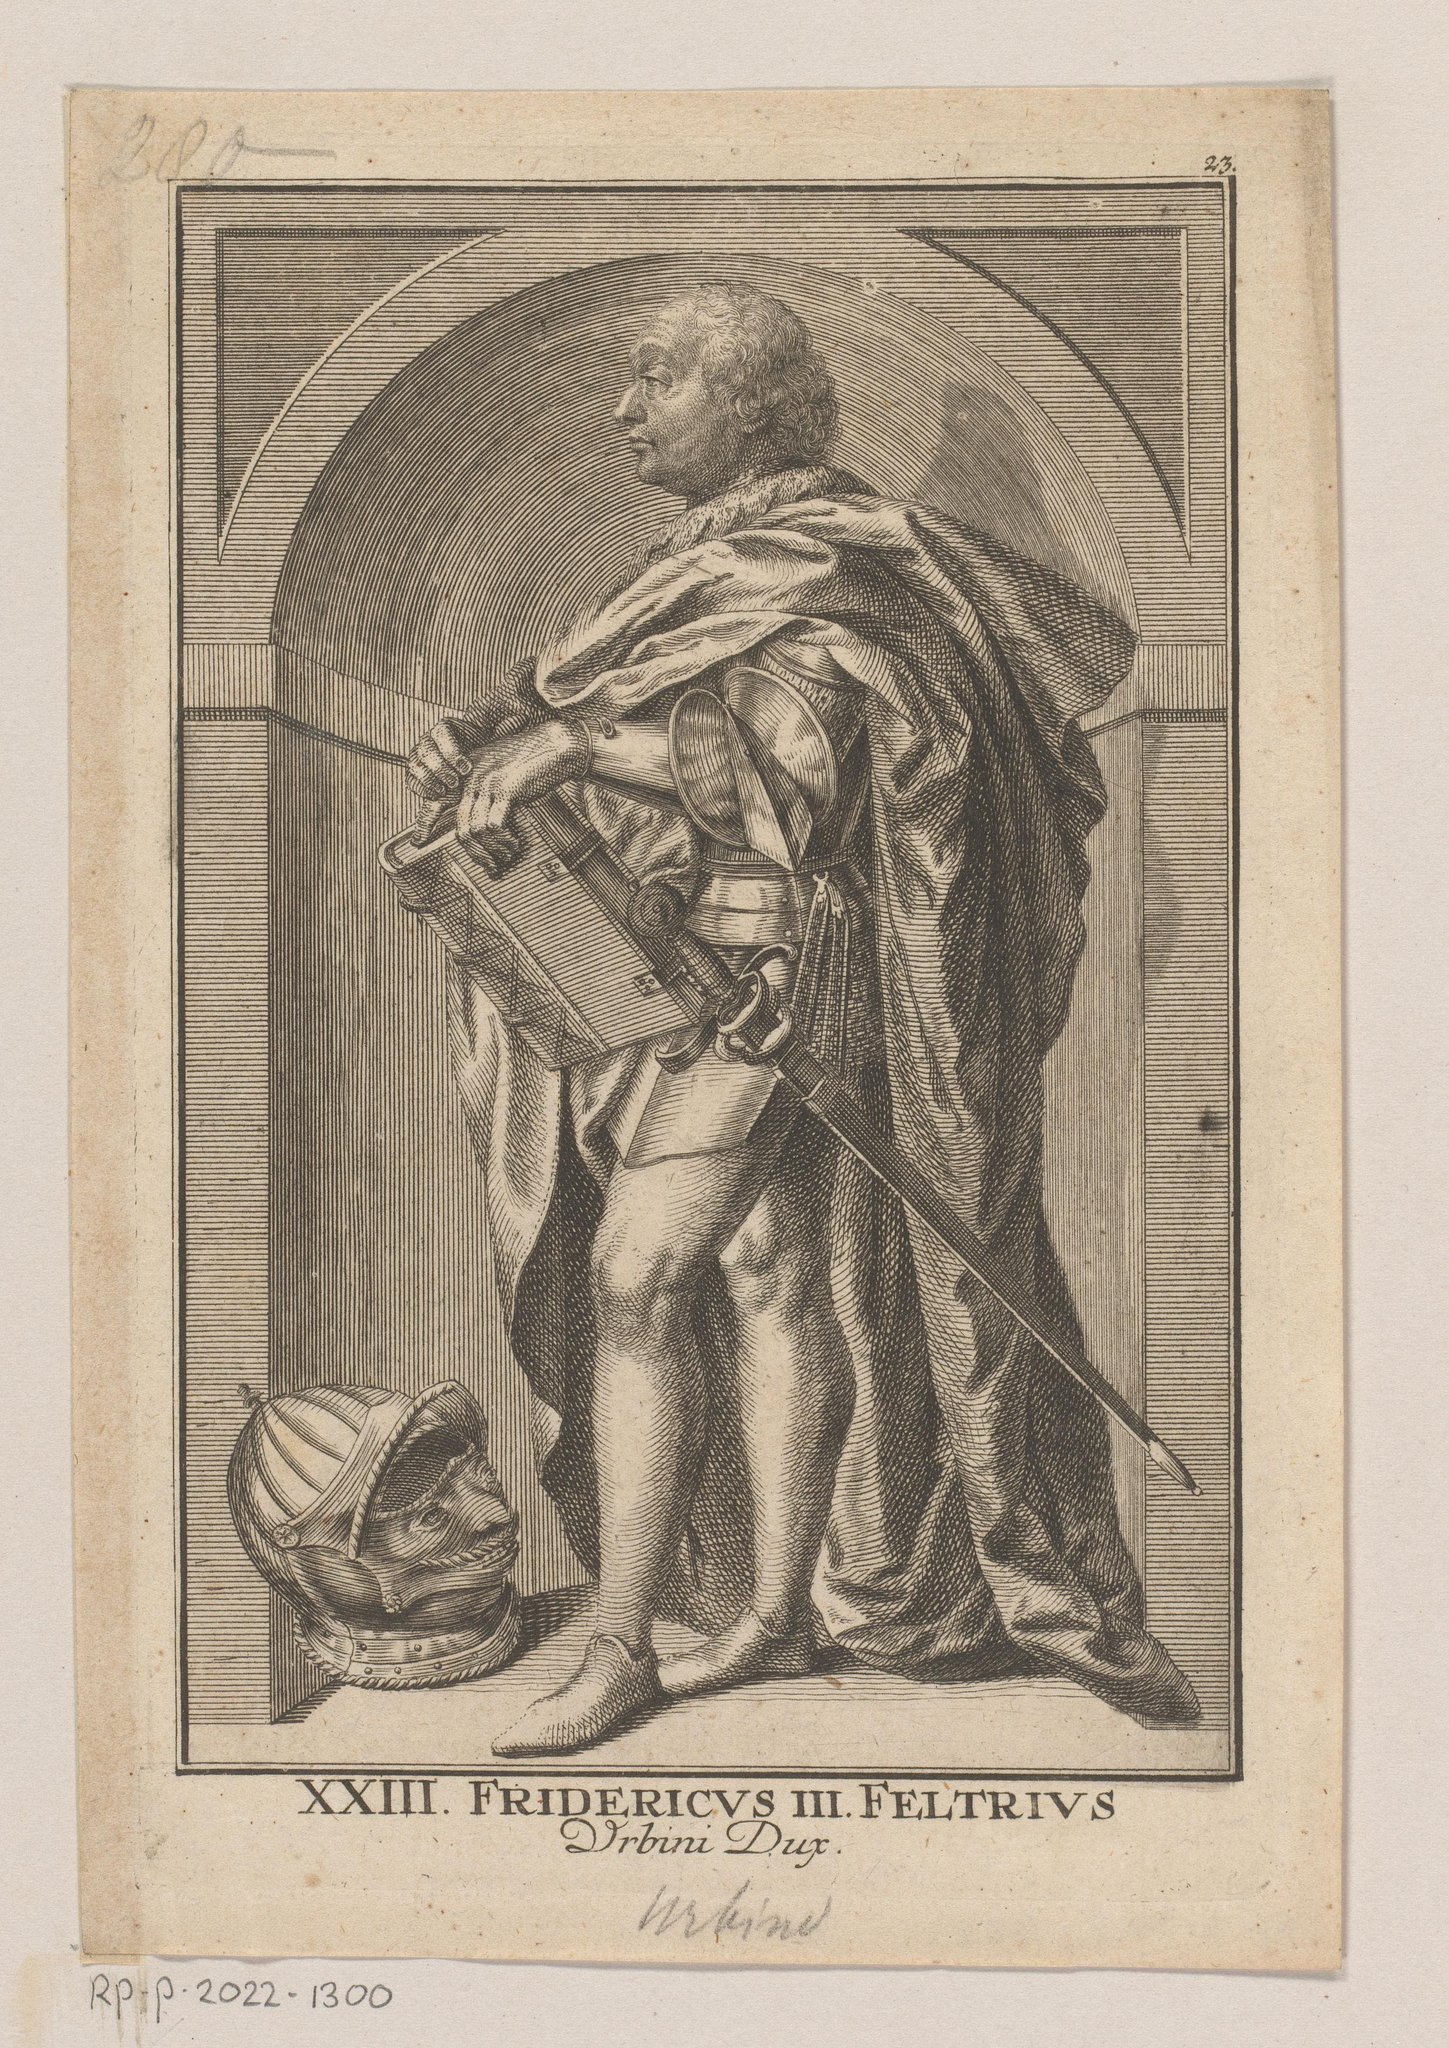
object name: book illustration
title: Portret van Federico da Montefeltro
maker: Anonymous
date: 1735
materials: paper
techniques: engraving, etching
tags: commander-in-chief, general, marshal, historical persons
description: Prent waarschijnlijk uit: Notzingen, Jacob Schrenck von. Armamentarium Heroicum Ambrasianum. Innsbruck: Johannes Agricola, 1735.